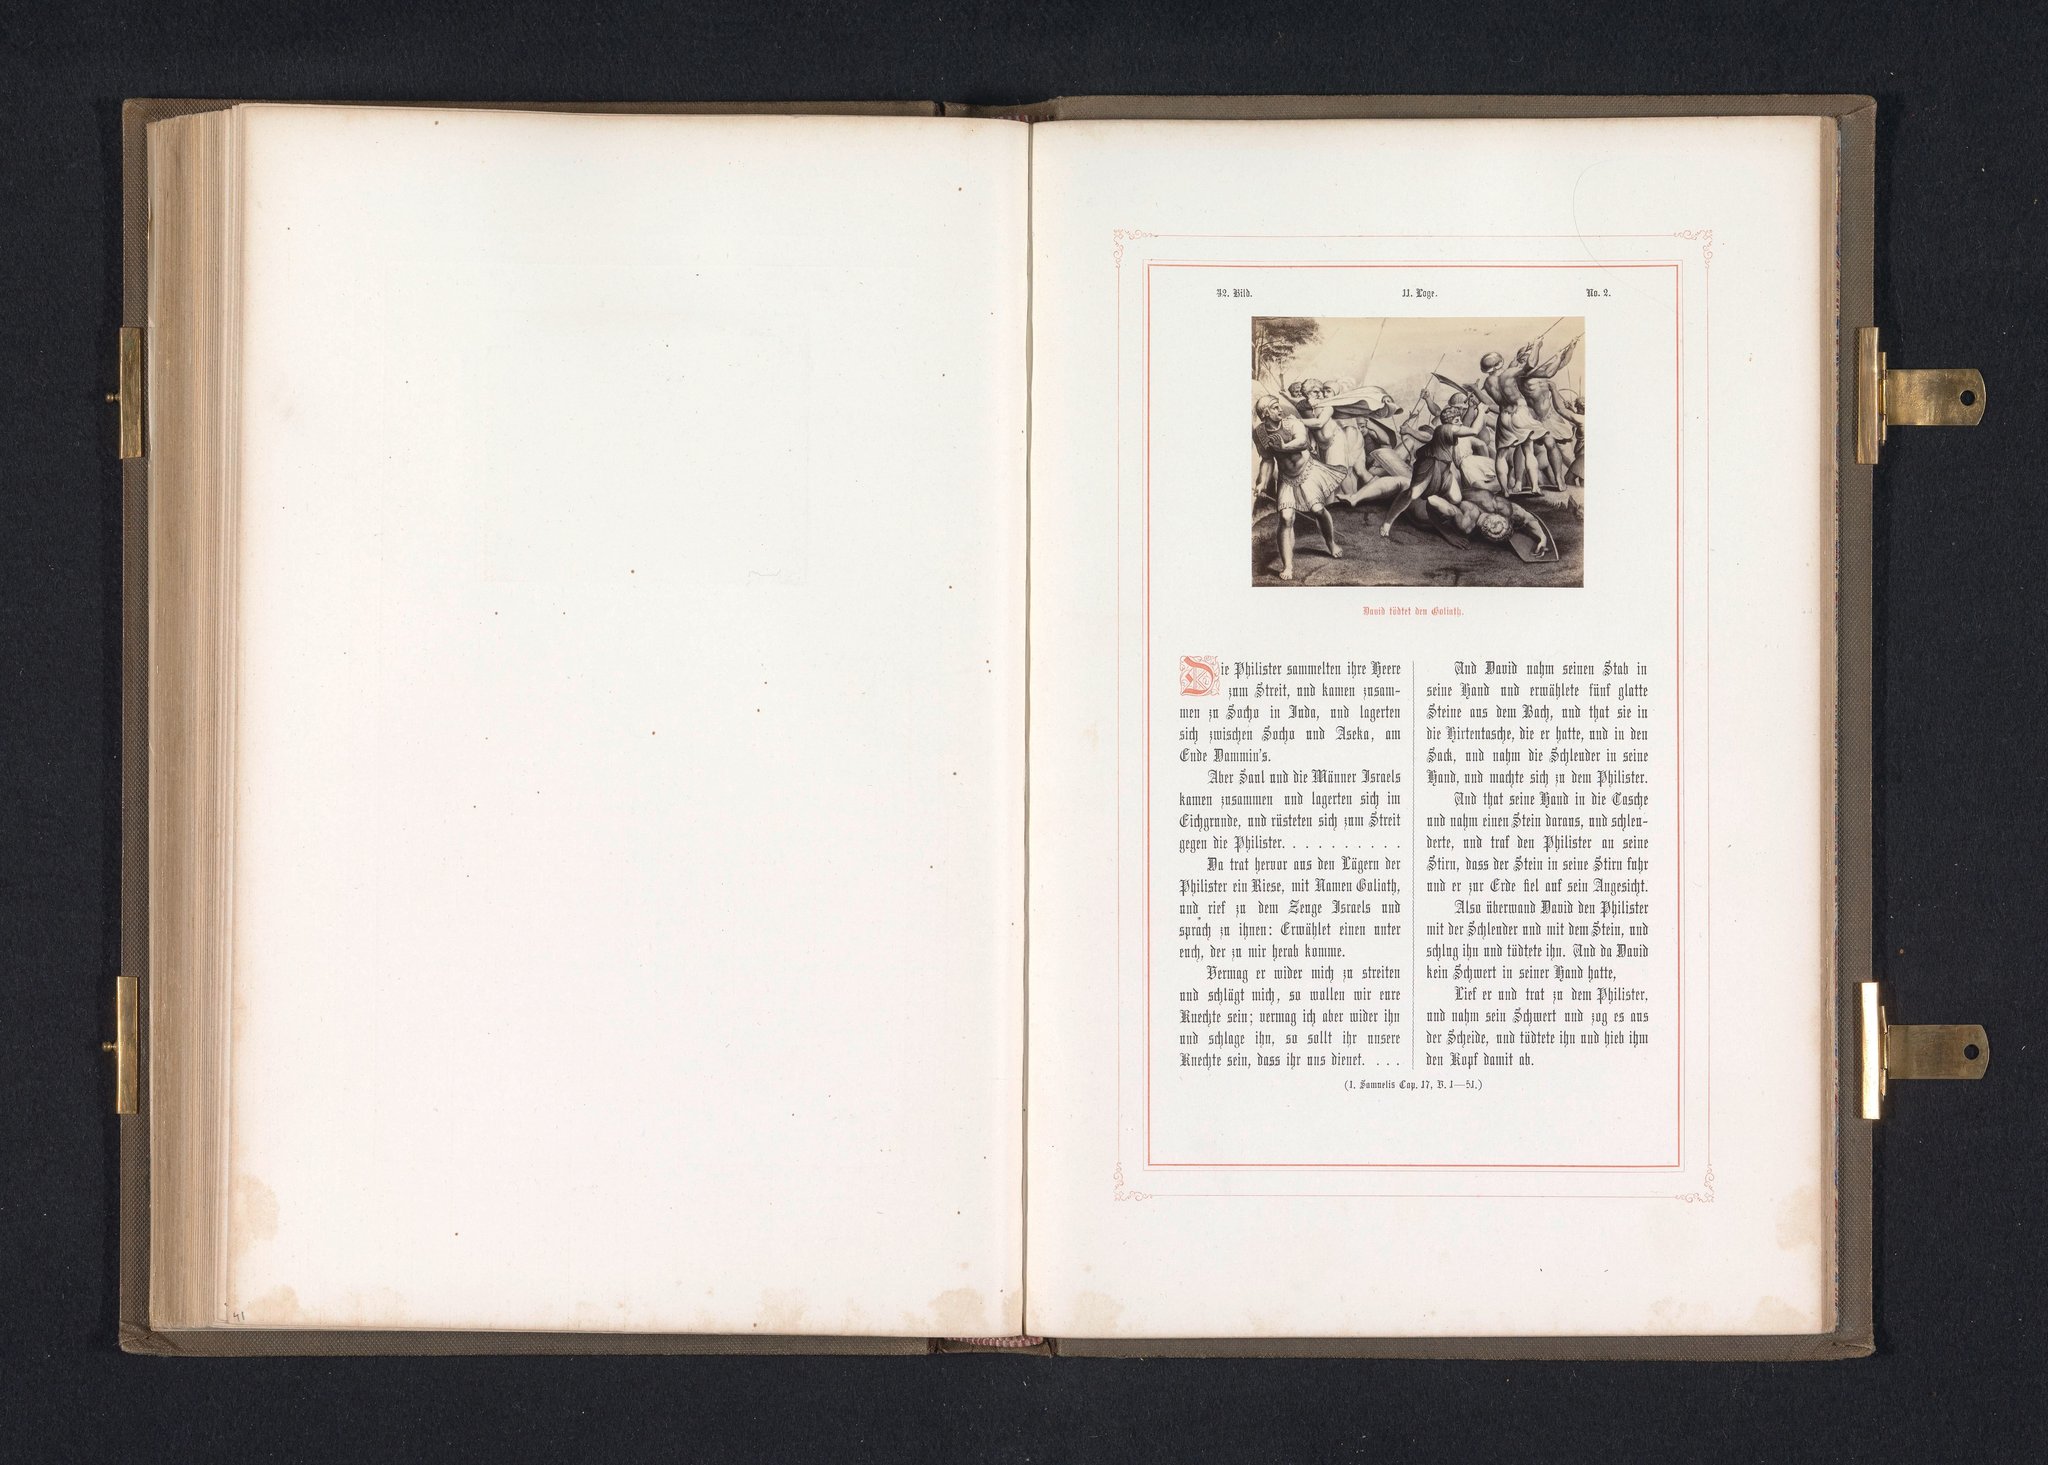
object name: page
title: David tödet den Goliath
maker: gustav schauer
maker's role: painter, publisher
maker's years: 1826-1902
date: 1851-1861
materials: photographic support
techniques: albumen print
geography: berlin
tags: david fighting goliath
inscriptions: inscription: ‘42. Bild. 11. Loge. No. 2.’